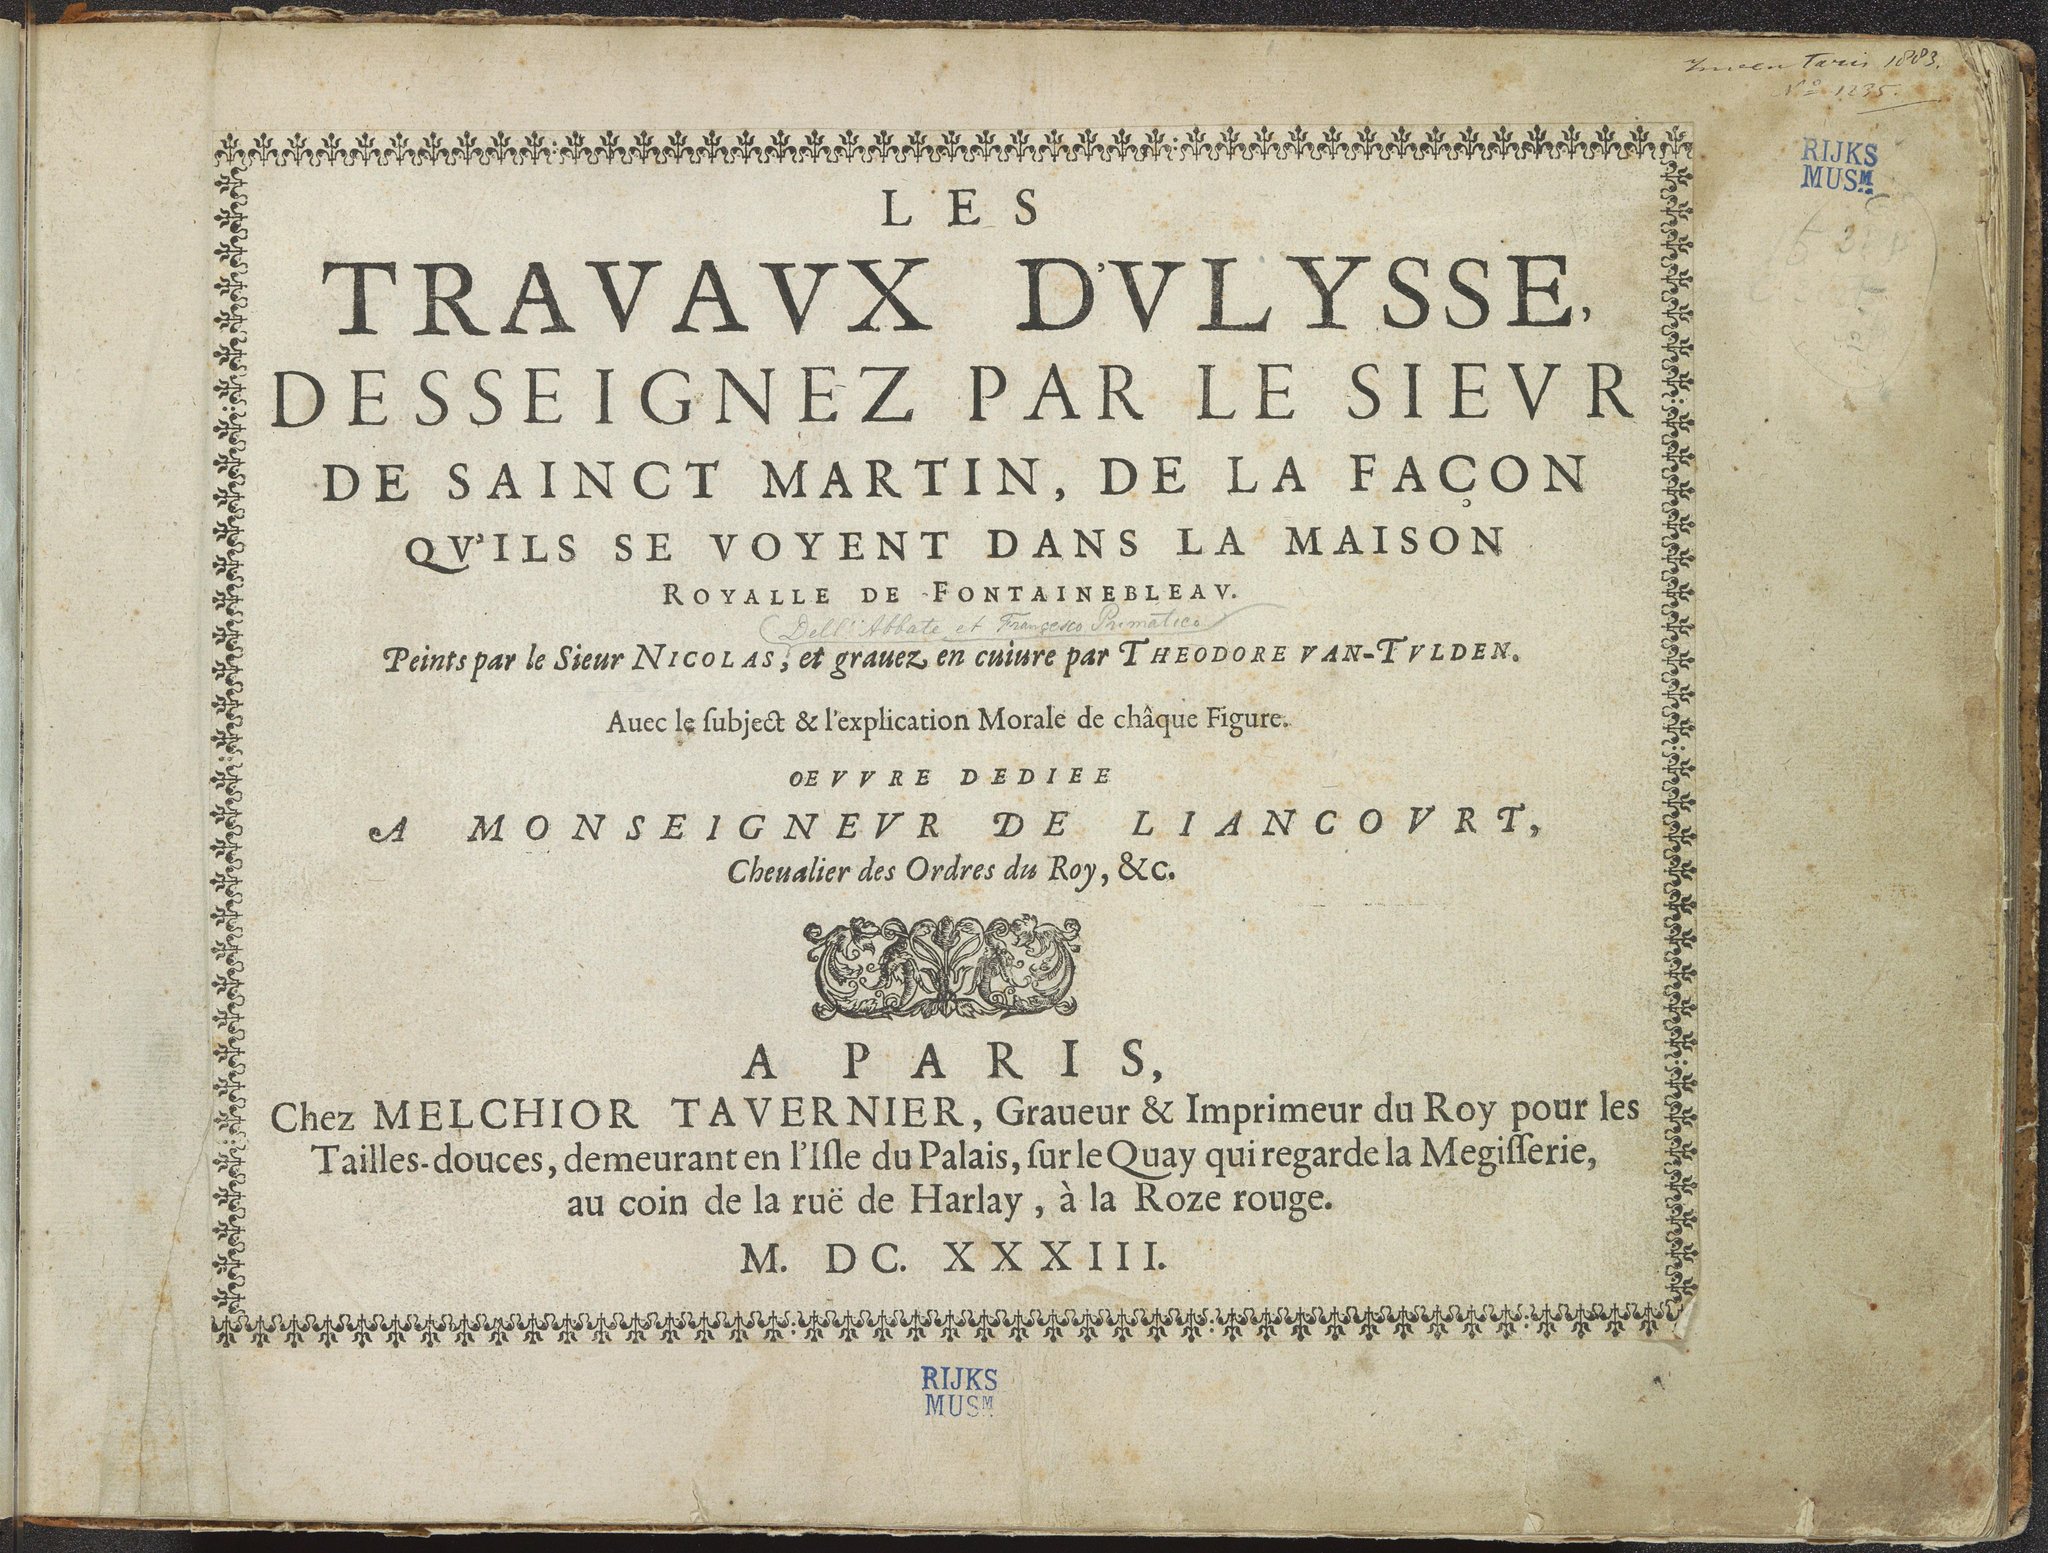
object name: titelblad, titelpagina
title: Titelpagina voor: Les Travaux d'Ulysse, 1633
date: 1633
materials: paper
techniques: letterpress printing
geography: paris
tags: title-page, ornamental decoration ~ printed matter, book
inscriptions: collector's mark: Lugt 2166, inscription: ‘Inventaris 1883 no 1235’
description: Titelpagina voor: Les Travaux d'Ulysse. Met een vignet van bladmotieven en mascarons en een ornamentrand van fleurons. De pagina maakt deel uit van een album.